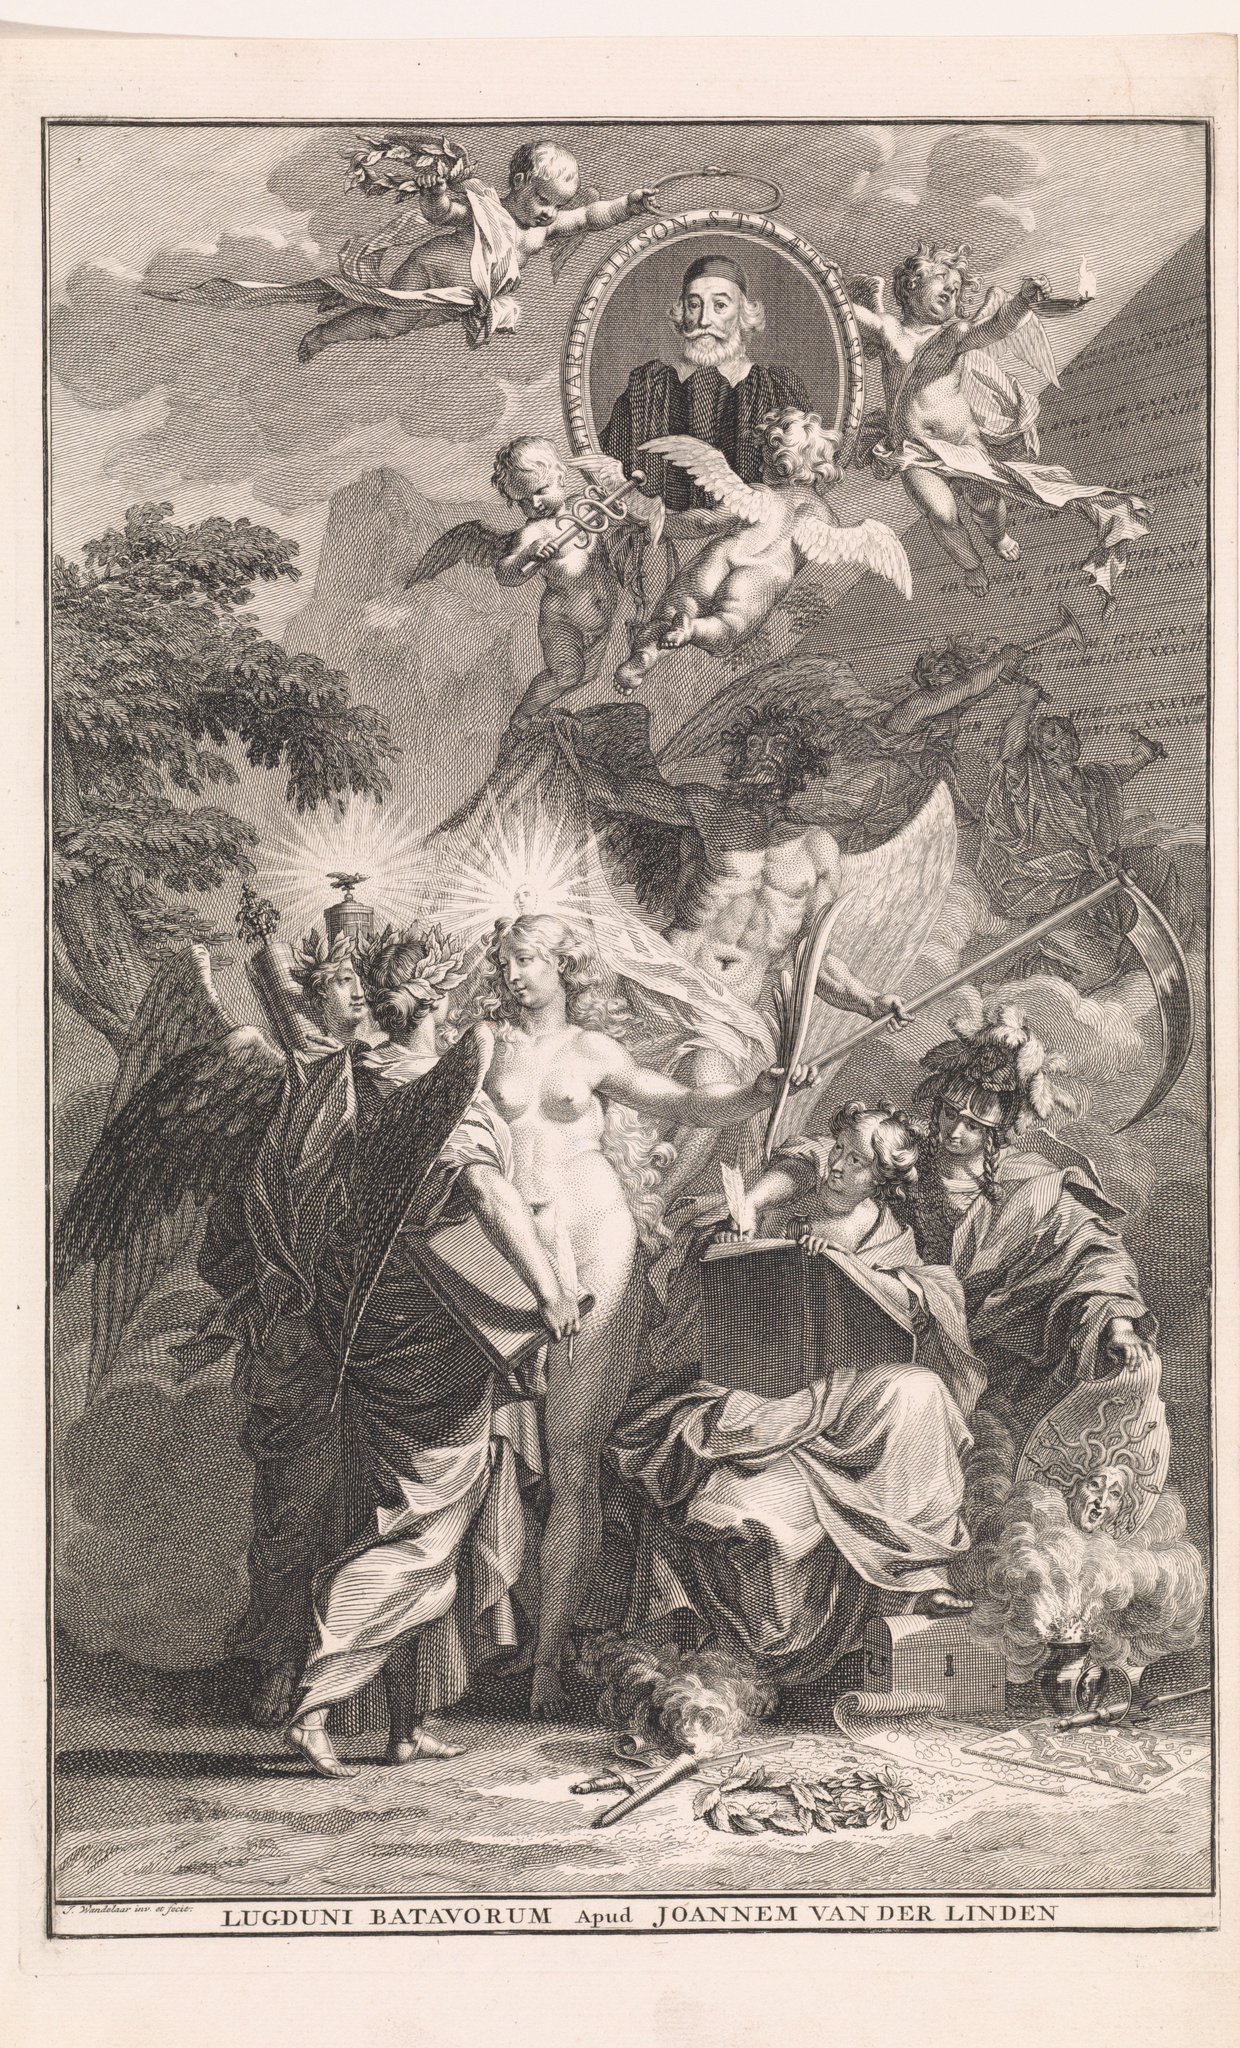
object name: print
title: Allegorische titelpagina met het portret van schrijver Edward Simson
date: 1752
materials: paper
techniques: engraving, etching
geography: northern netherlands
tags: (story of) minerva (pallas, athena), eternity, 'aeternitas'; 'eternità','eternità o perpetuità' (ripa), truth; 'verità' (ripa), symbolic representations, allegories and emblems ~ poetry; 'poesia' (ripa), pyramid (historical grave form), 'historia'; 'historia' (ripa), fame; 'fama', 'fama buona', 'fama chiara' (ripa), father time, man with wings and scythe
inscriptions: collector's mark: Lugt 2228, collector's mark: Lugt 2760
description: Minerva zit naast Geschiedenis en kijkt over haar schouder mee naar het boek waarin zij schrijft. Geschiedenis kijkt op naar drie allegorische vrouwfiguren (Waarheid, Poëzie en een derde figuur). Achter hen Vader Tijd, Faam en een tweehoofdige figuur die met een beitel een inscriptie slaat in een piramide. In de lucht vliegen vier putti, met eeuwigheidsymbolen in de handen, die het portret van schrijver Edward Simson meevoeren.